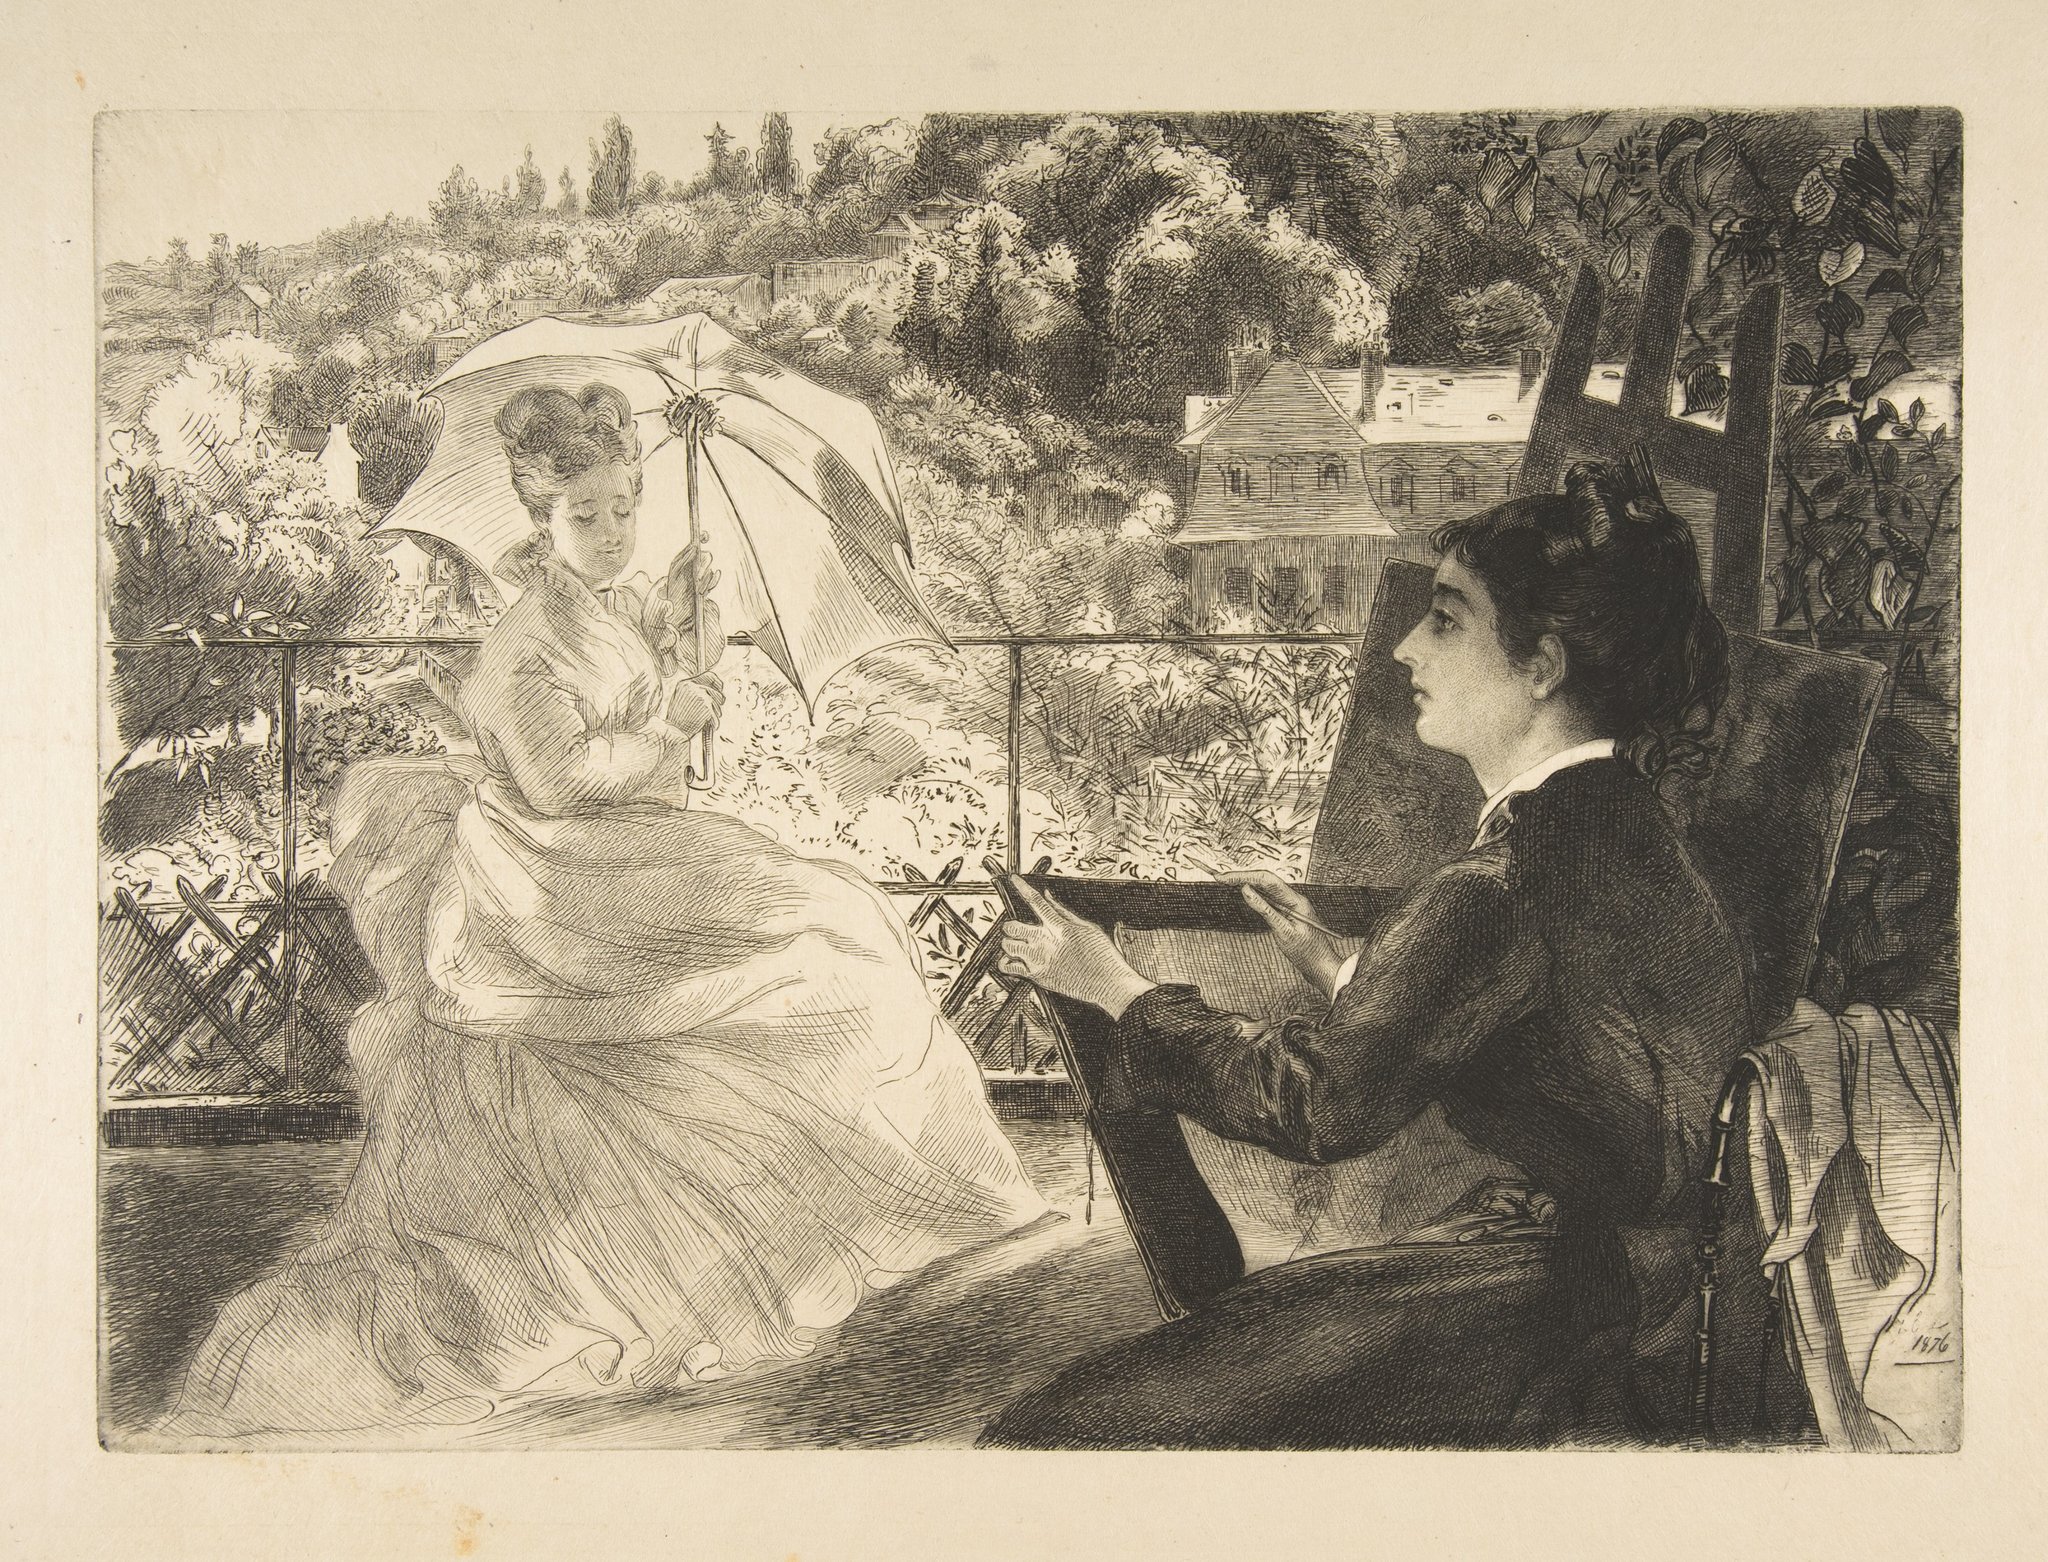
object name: print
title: La Terrasse de la Villa Brancas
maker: félix bracquemond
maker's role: artist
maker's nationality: french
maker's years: 1833-1914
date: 1876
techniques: drypoint, etching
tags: painting,women